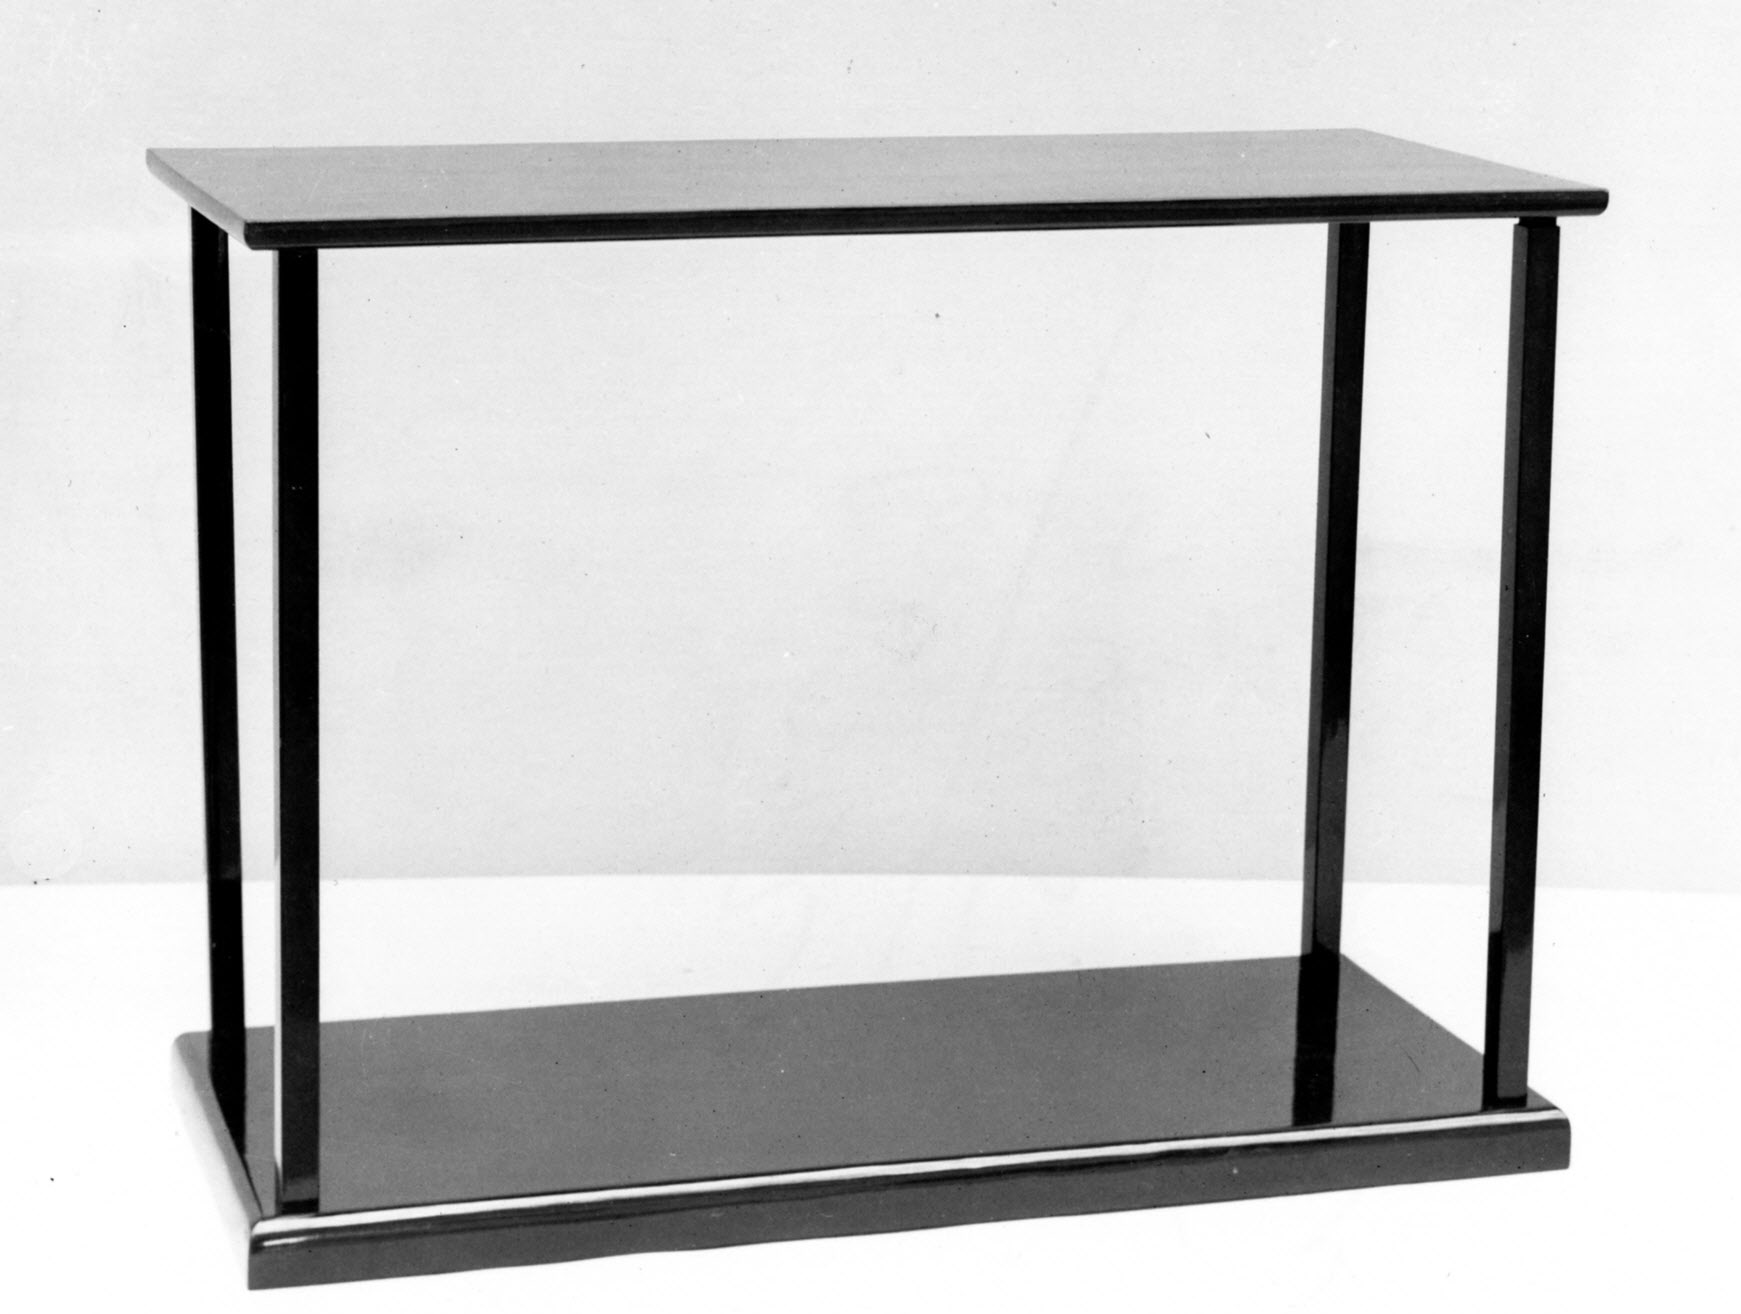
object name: table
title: Table for Tea Ceremony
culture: japanese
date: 1701-1800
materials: lacquer